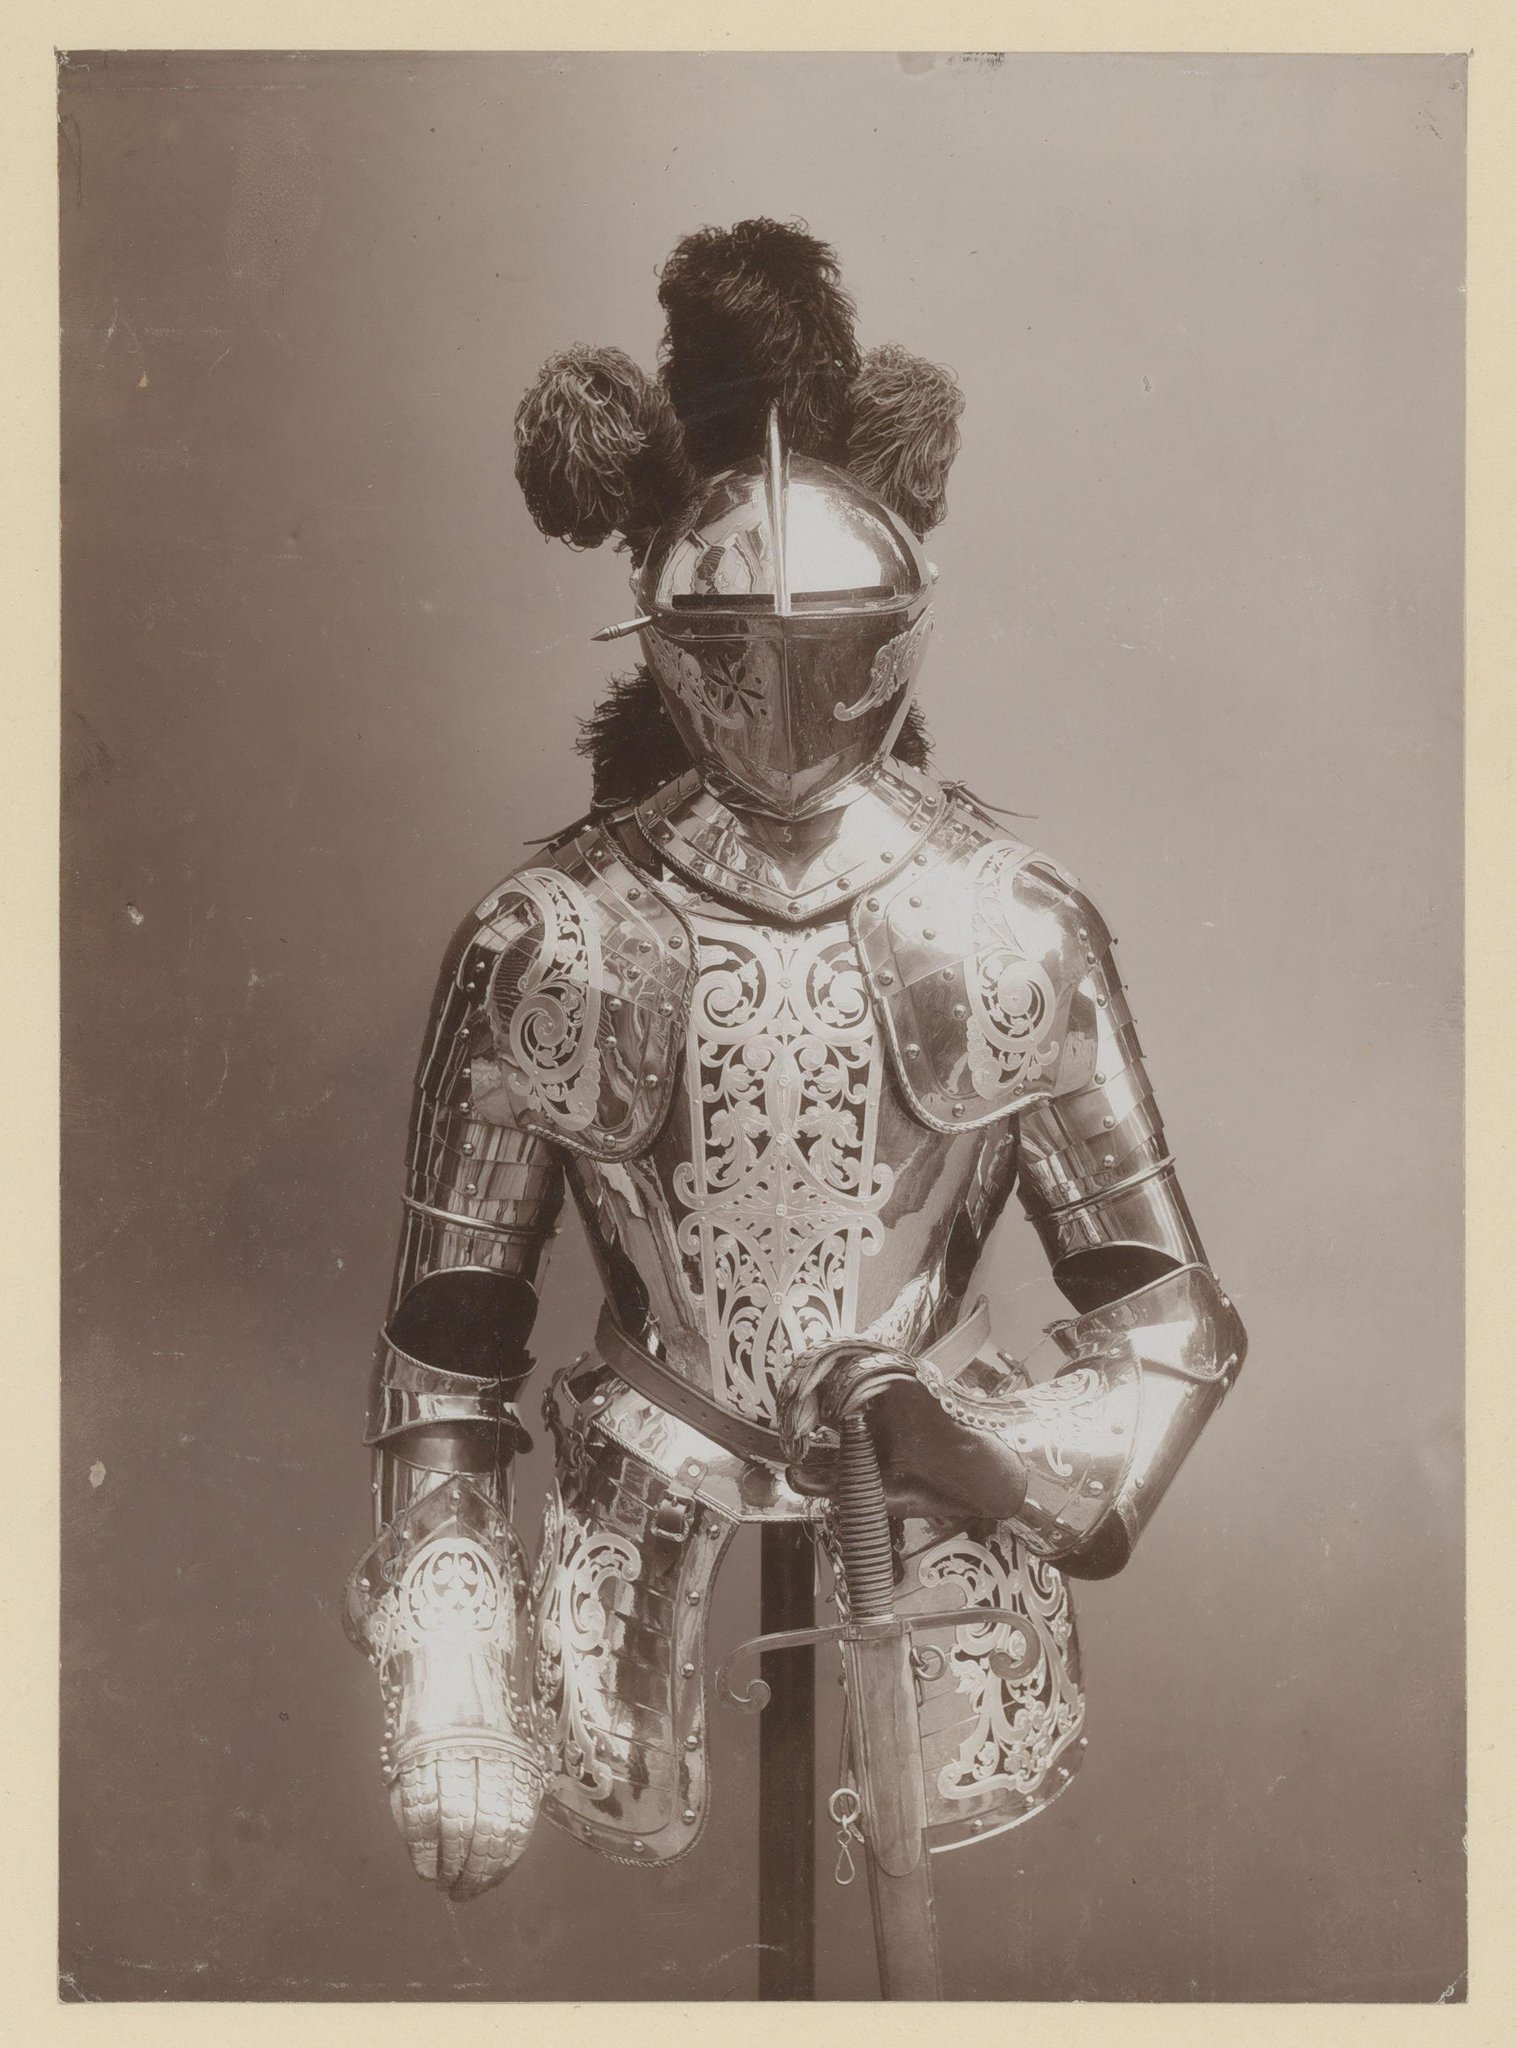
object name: photograph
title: Replica van het harnas van Franz Christoph von Khevenhüller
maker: jean jacques antoine van winsen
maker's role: fotograaf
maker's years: 1851-1927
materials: paper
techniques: albumen print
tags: franz christoph von khevenhüller, (medieval) fighting contest, harness, utrecht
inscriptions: collector's mark: Lugt 1641, stamp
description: Replica van het harnas van Franz Christoph von Khevenhüller, gemaakt door Koninklijke Utrechtse Fabriek van Zilverwerken C.J. Begeer. Gemaakt ter gelegenheid van de Ridderhofspelen gehouden tussen 24 en 26 juni 1896 in Utrecht ter gelegenheid van het 52e lustrum van de Universiteit. Het thema van de Ridderhofspelen is het Ridderhofspel te Wenen in 1560. Onderwerpsrubrieken binnen de Atlas Zeden en Gewoonten: Onderwijs en Wetenschappen, Studentenleven.